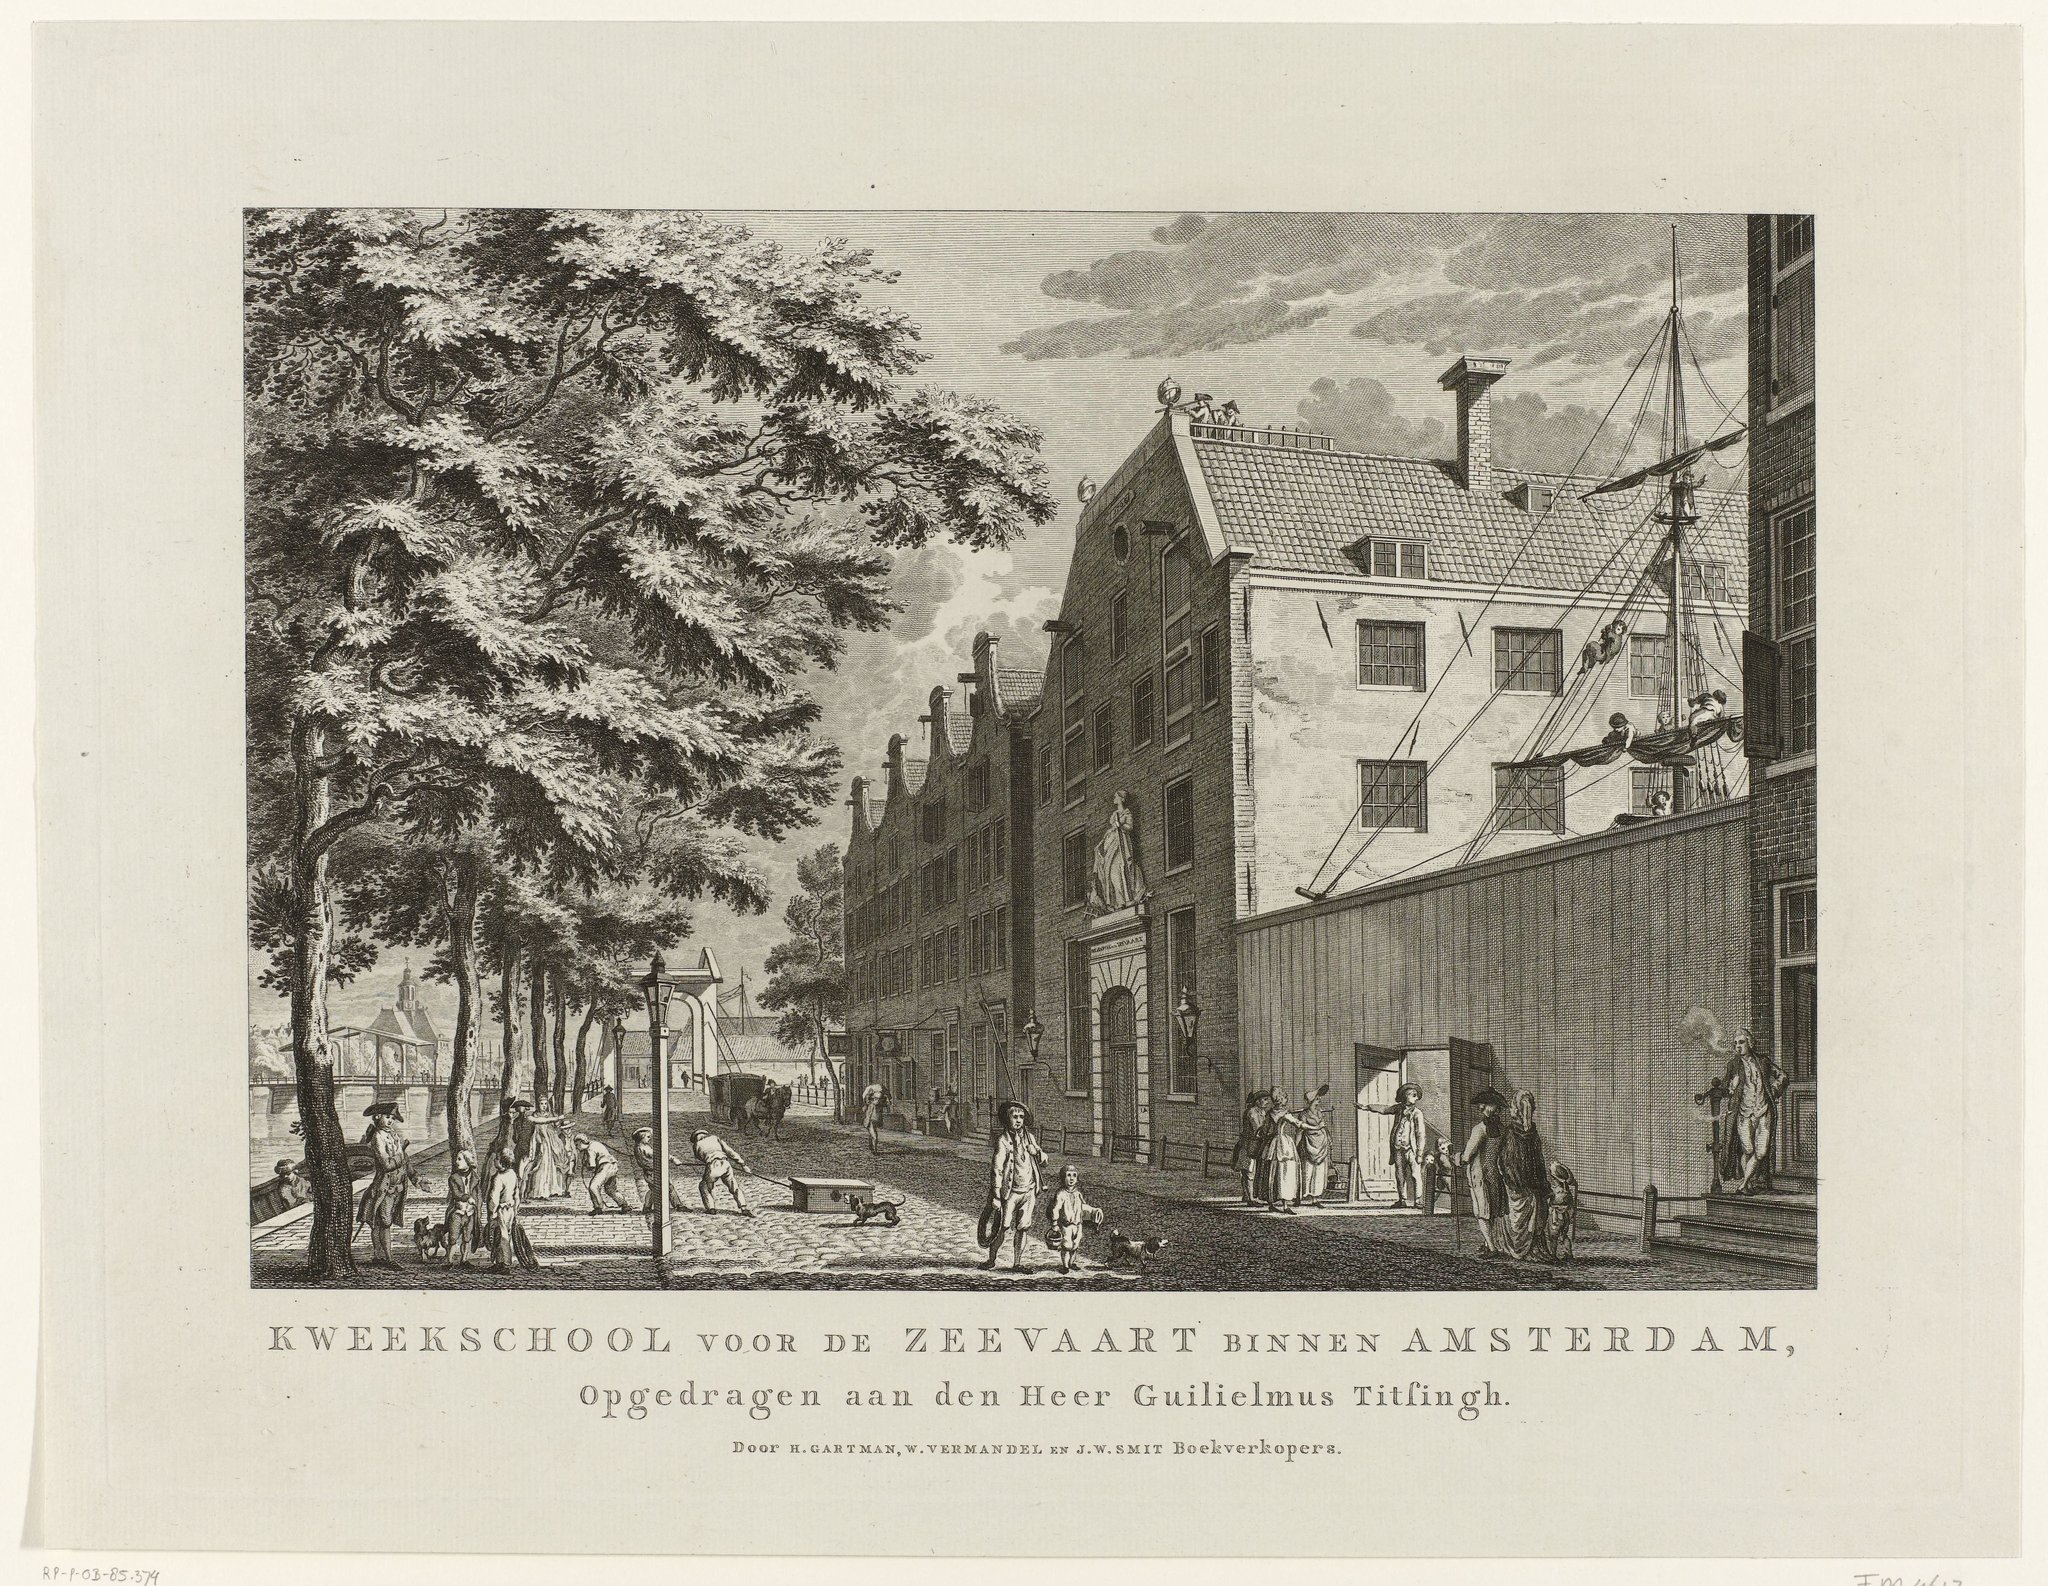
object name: print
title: Gezicht op de Kweekschool voor de Zeevaart te Amsterdam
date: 1784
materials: paper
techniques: engraving, etching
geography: northern netherlands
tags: secondary education (+ building ~ education, tuition)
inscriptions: collector's mark: Lugt 2228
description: Gezicht op de Kweekschool voor de Zeevaart, gelegen aan de Buitenkant te Amsterdam, opgericht december 1784. De prent is opgedragen aan Willem Titsingh, initiatiefnemer tot de oprichting van de school.